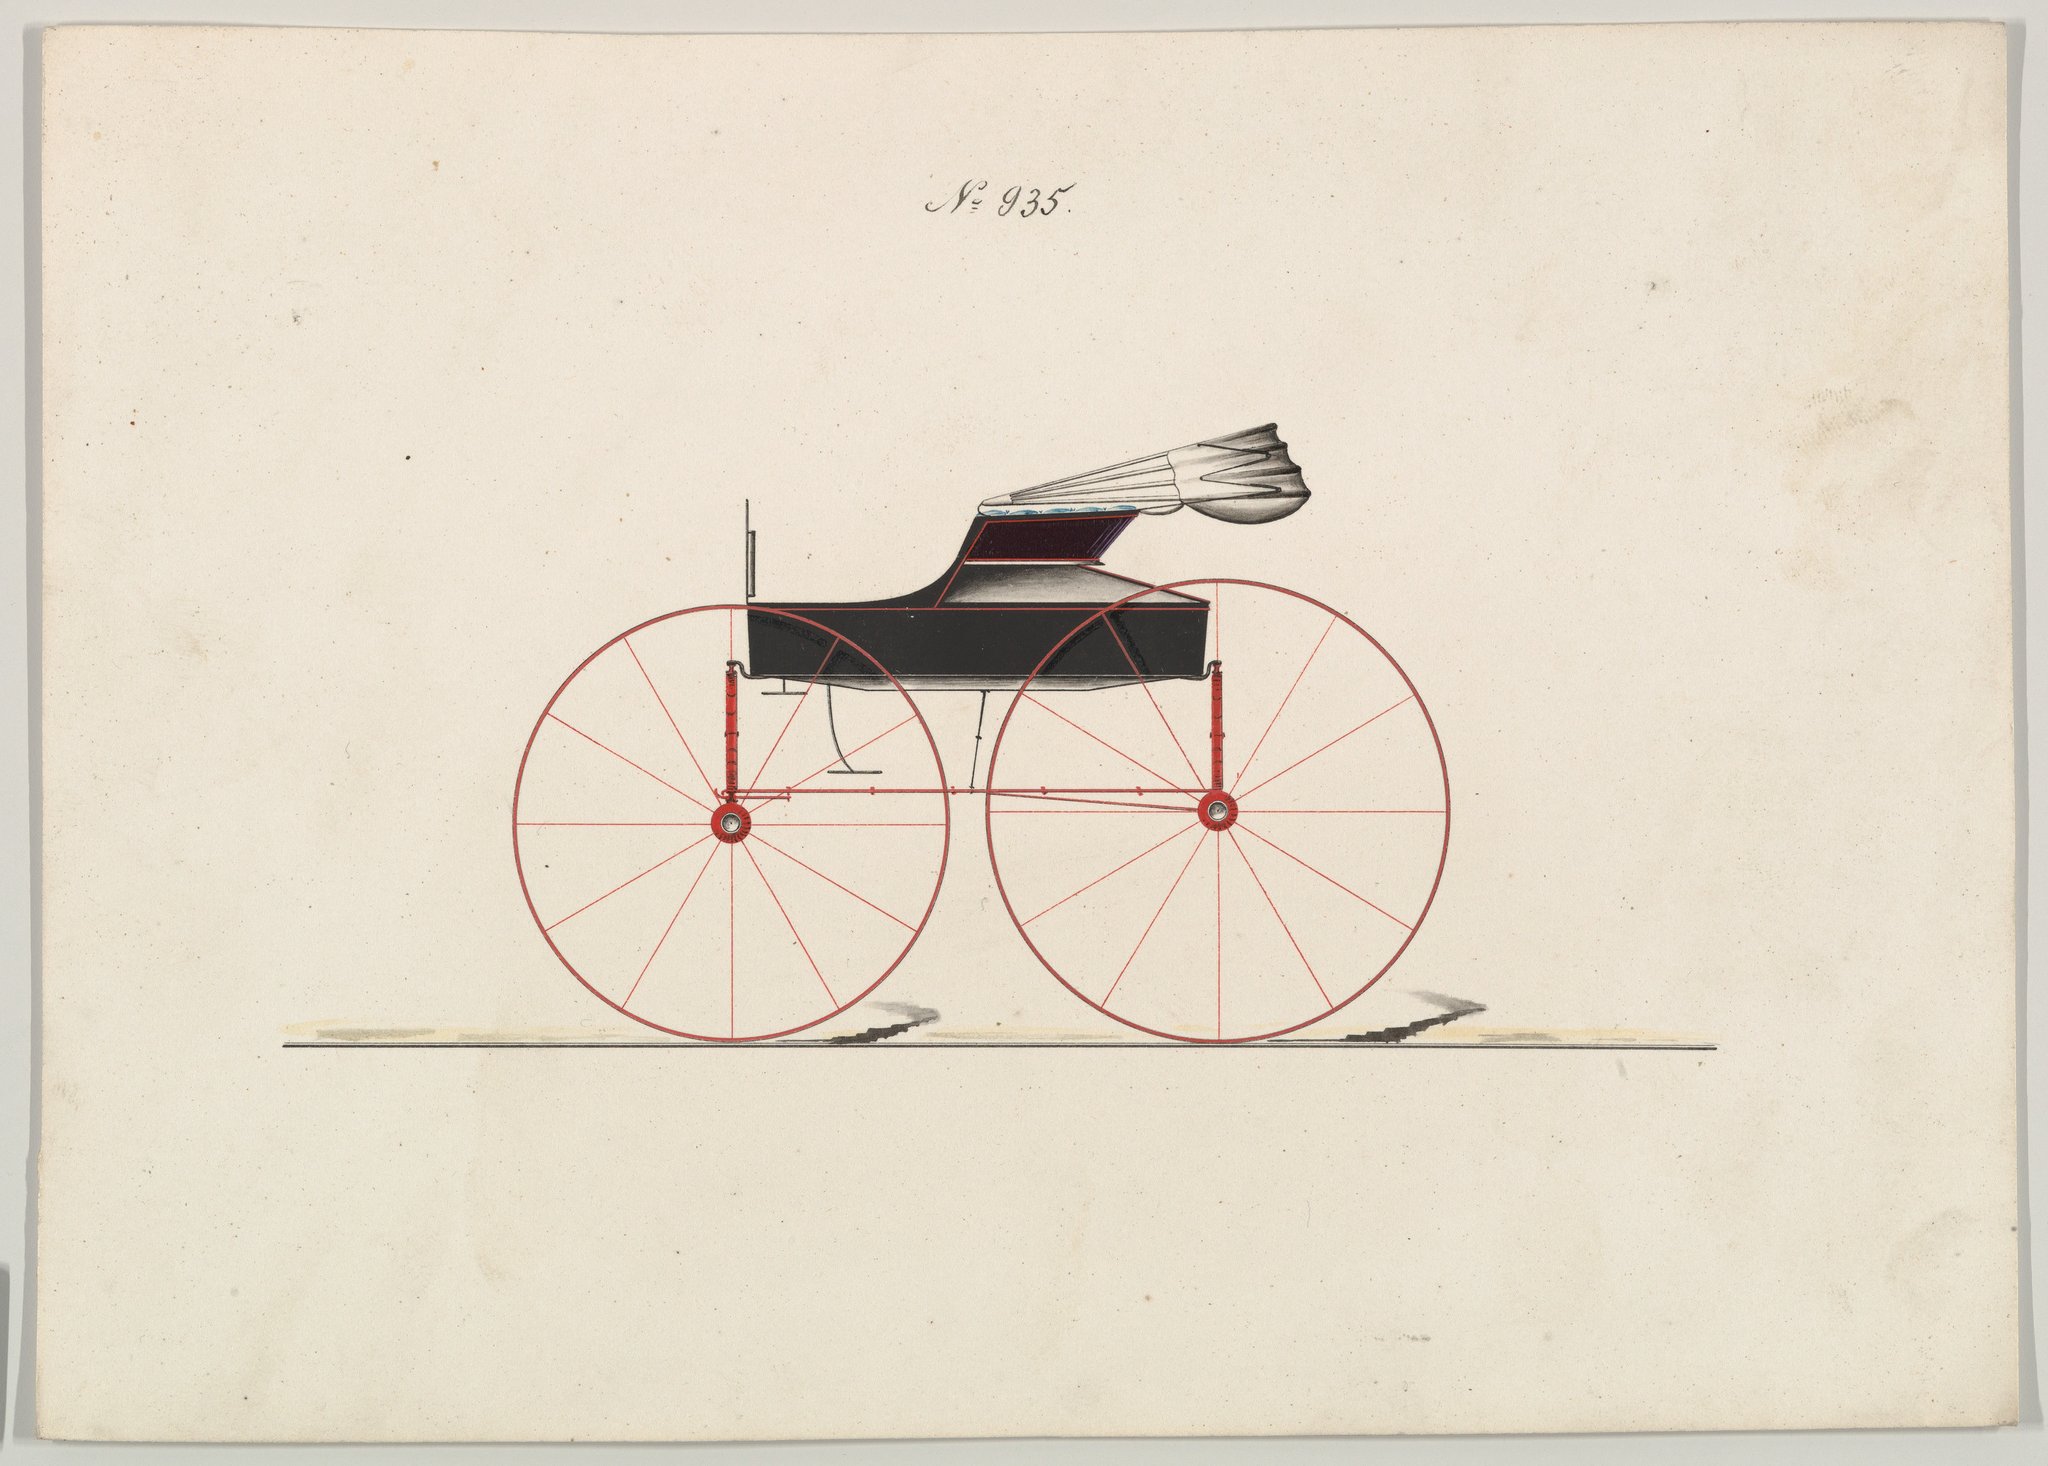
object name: drawing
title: Design for Wagon, no. 935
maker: brewster & co.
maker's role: manufacturer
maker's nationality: american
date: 1850-1870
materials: gouache, gum arabic, ink, watercolor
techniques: pen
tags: carriages